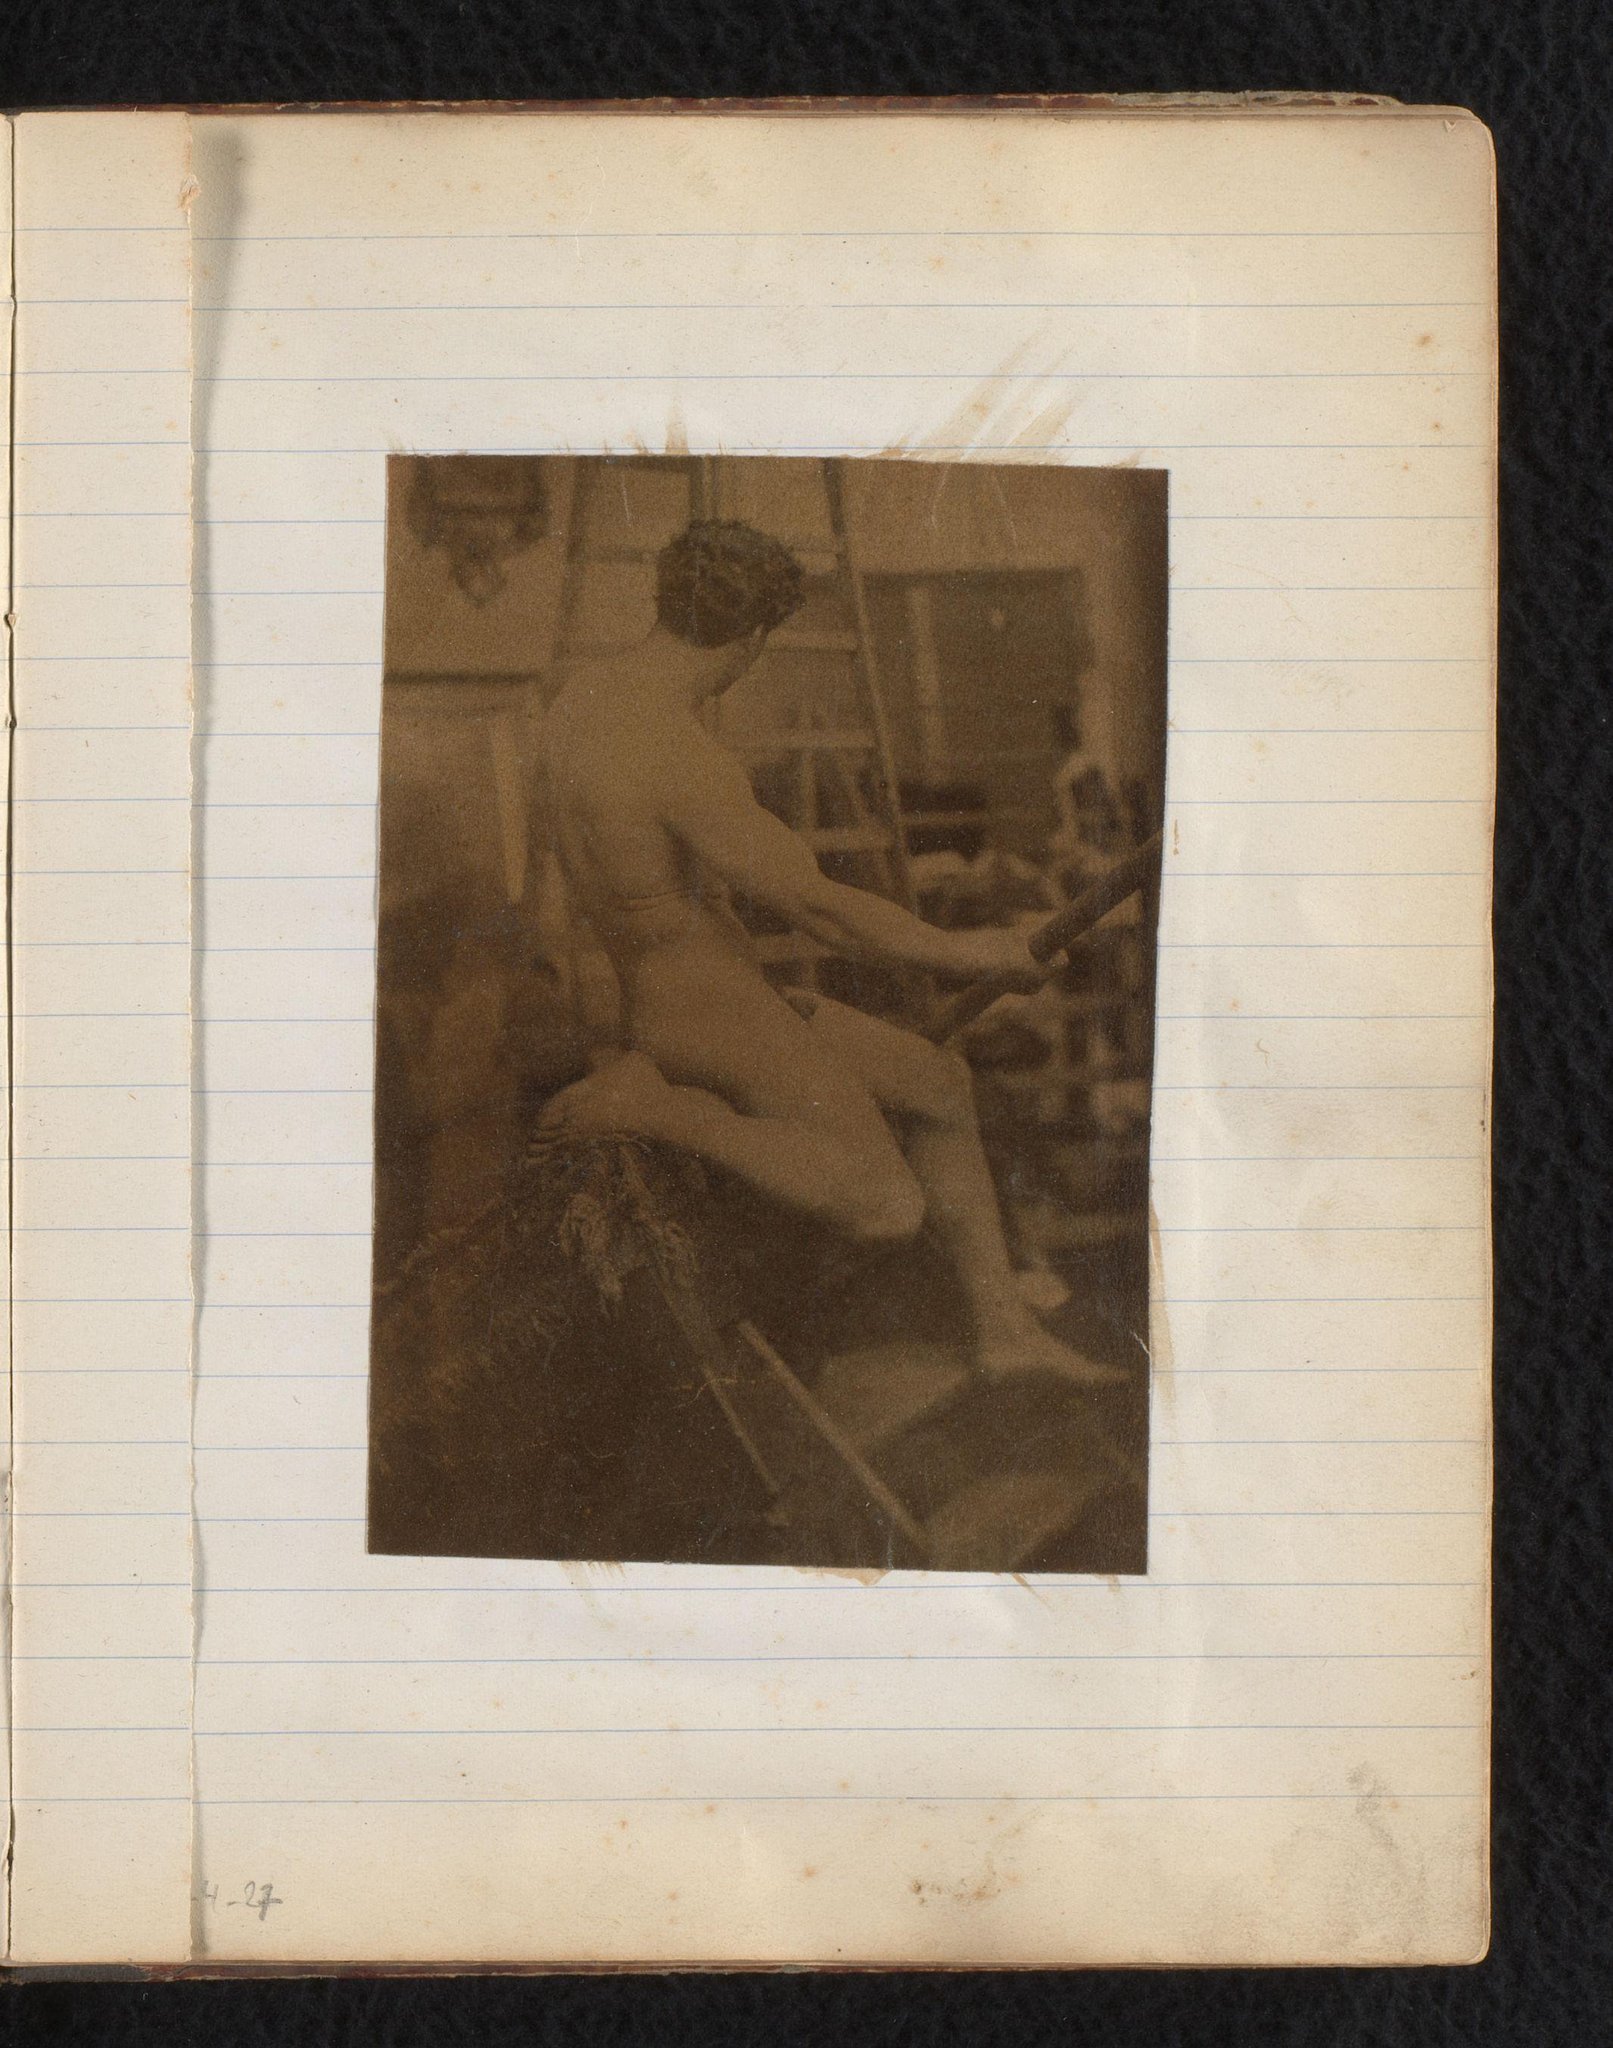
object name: photograph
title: Studie van een mannelijk naaktmodel, op de rug gezien, in het atelier van Jacques de Lalaing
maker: jacques lalaing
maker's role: painter, sculptor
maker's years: 1858-1917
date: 1883-1914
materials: photographic support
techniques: albumen print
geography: brussels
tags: adult man, artist (in general) working from nude model, the (nude) human figure; 'corpo humano' (ripa) (+ back view)